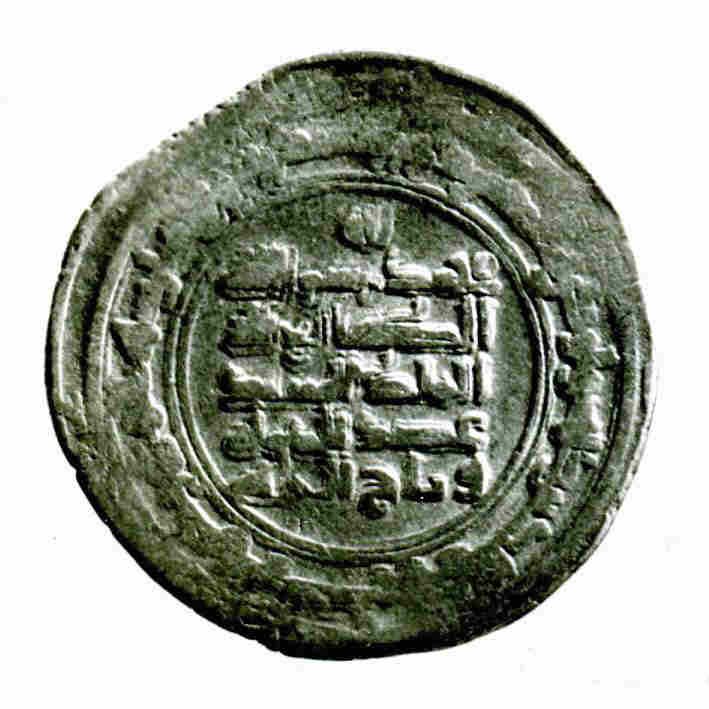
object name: coin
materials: silver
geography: iran